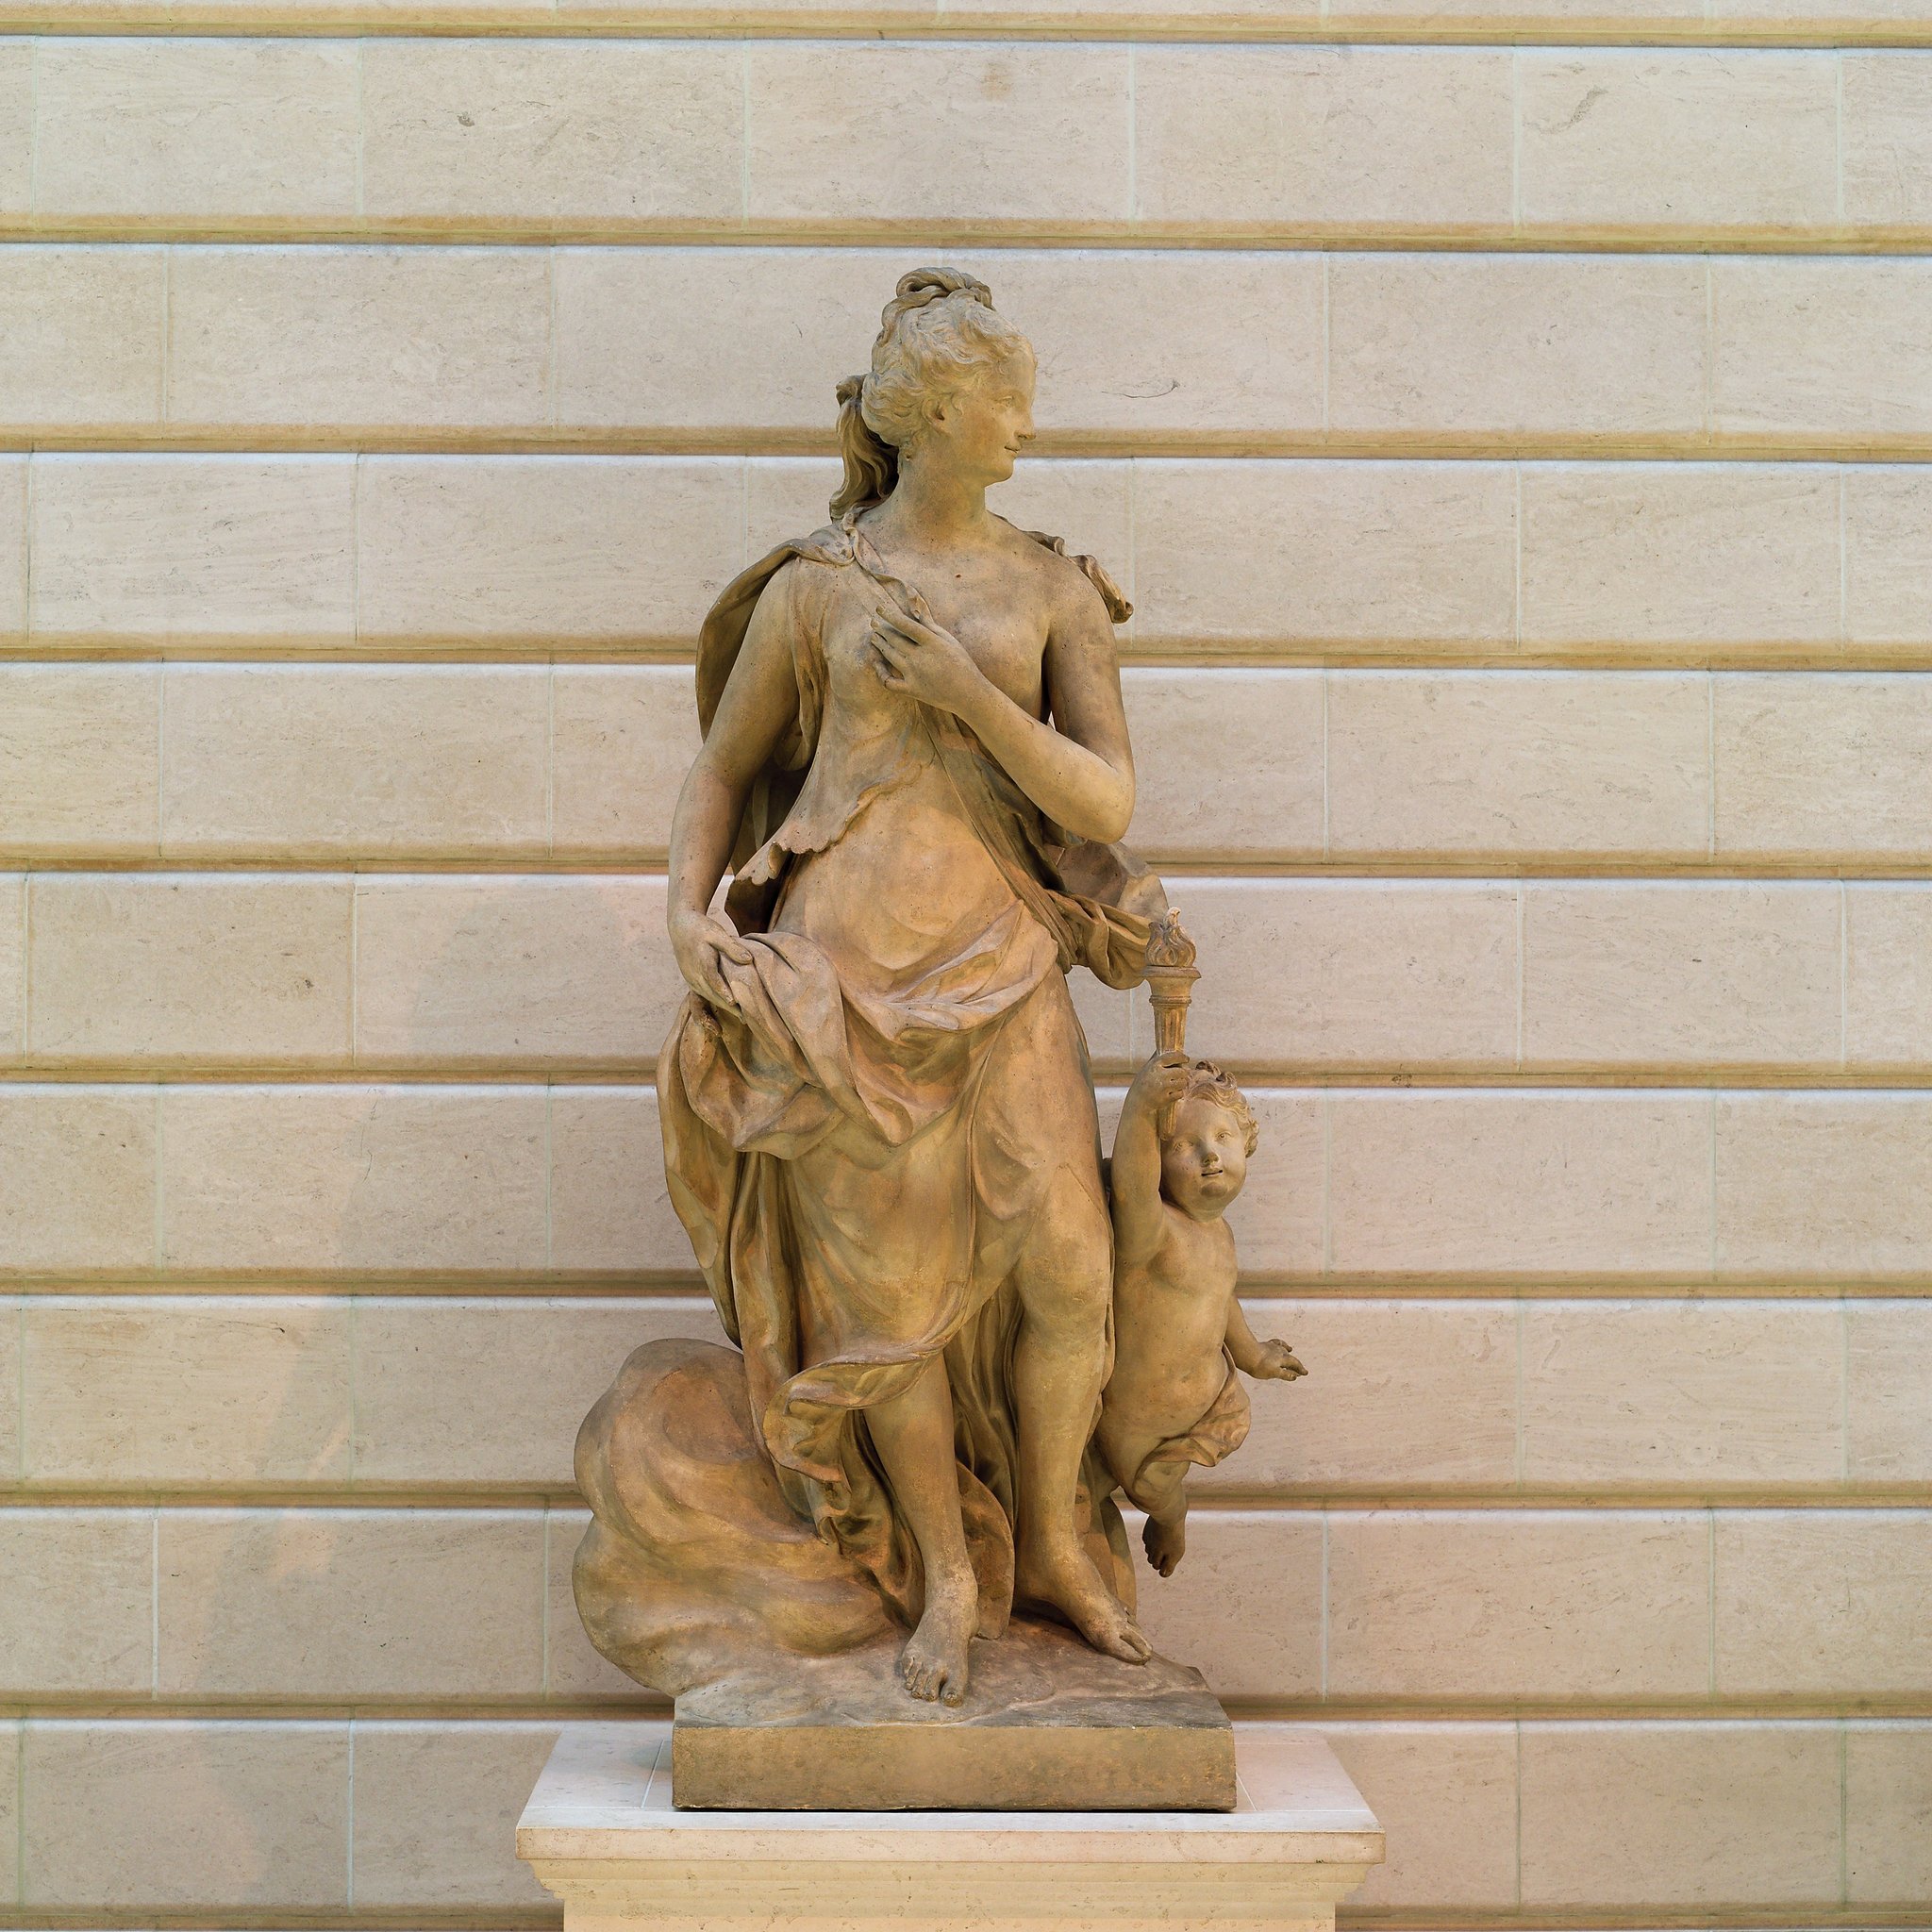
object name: statue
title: Fire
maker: jean-pierre defrance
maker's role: artist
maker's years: 1694-1768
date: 1750-1760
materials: limestone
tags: women,putti